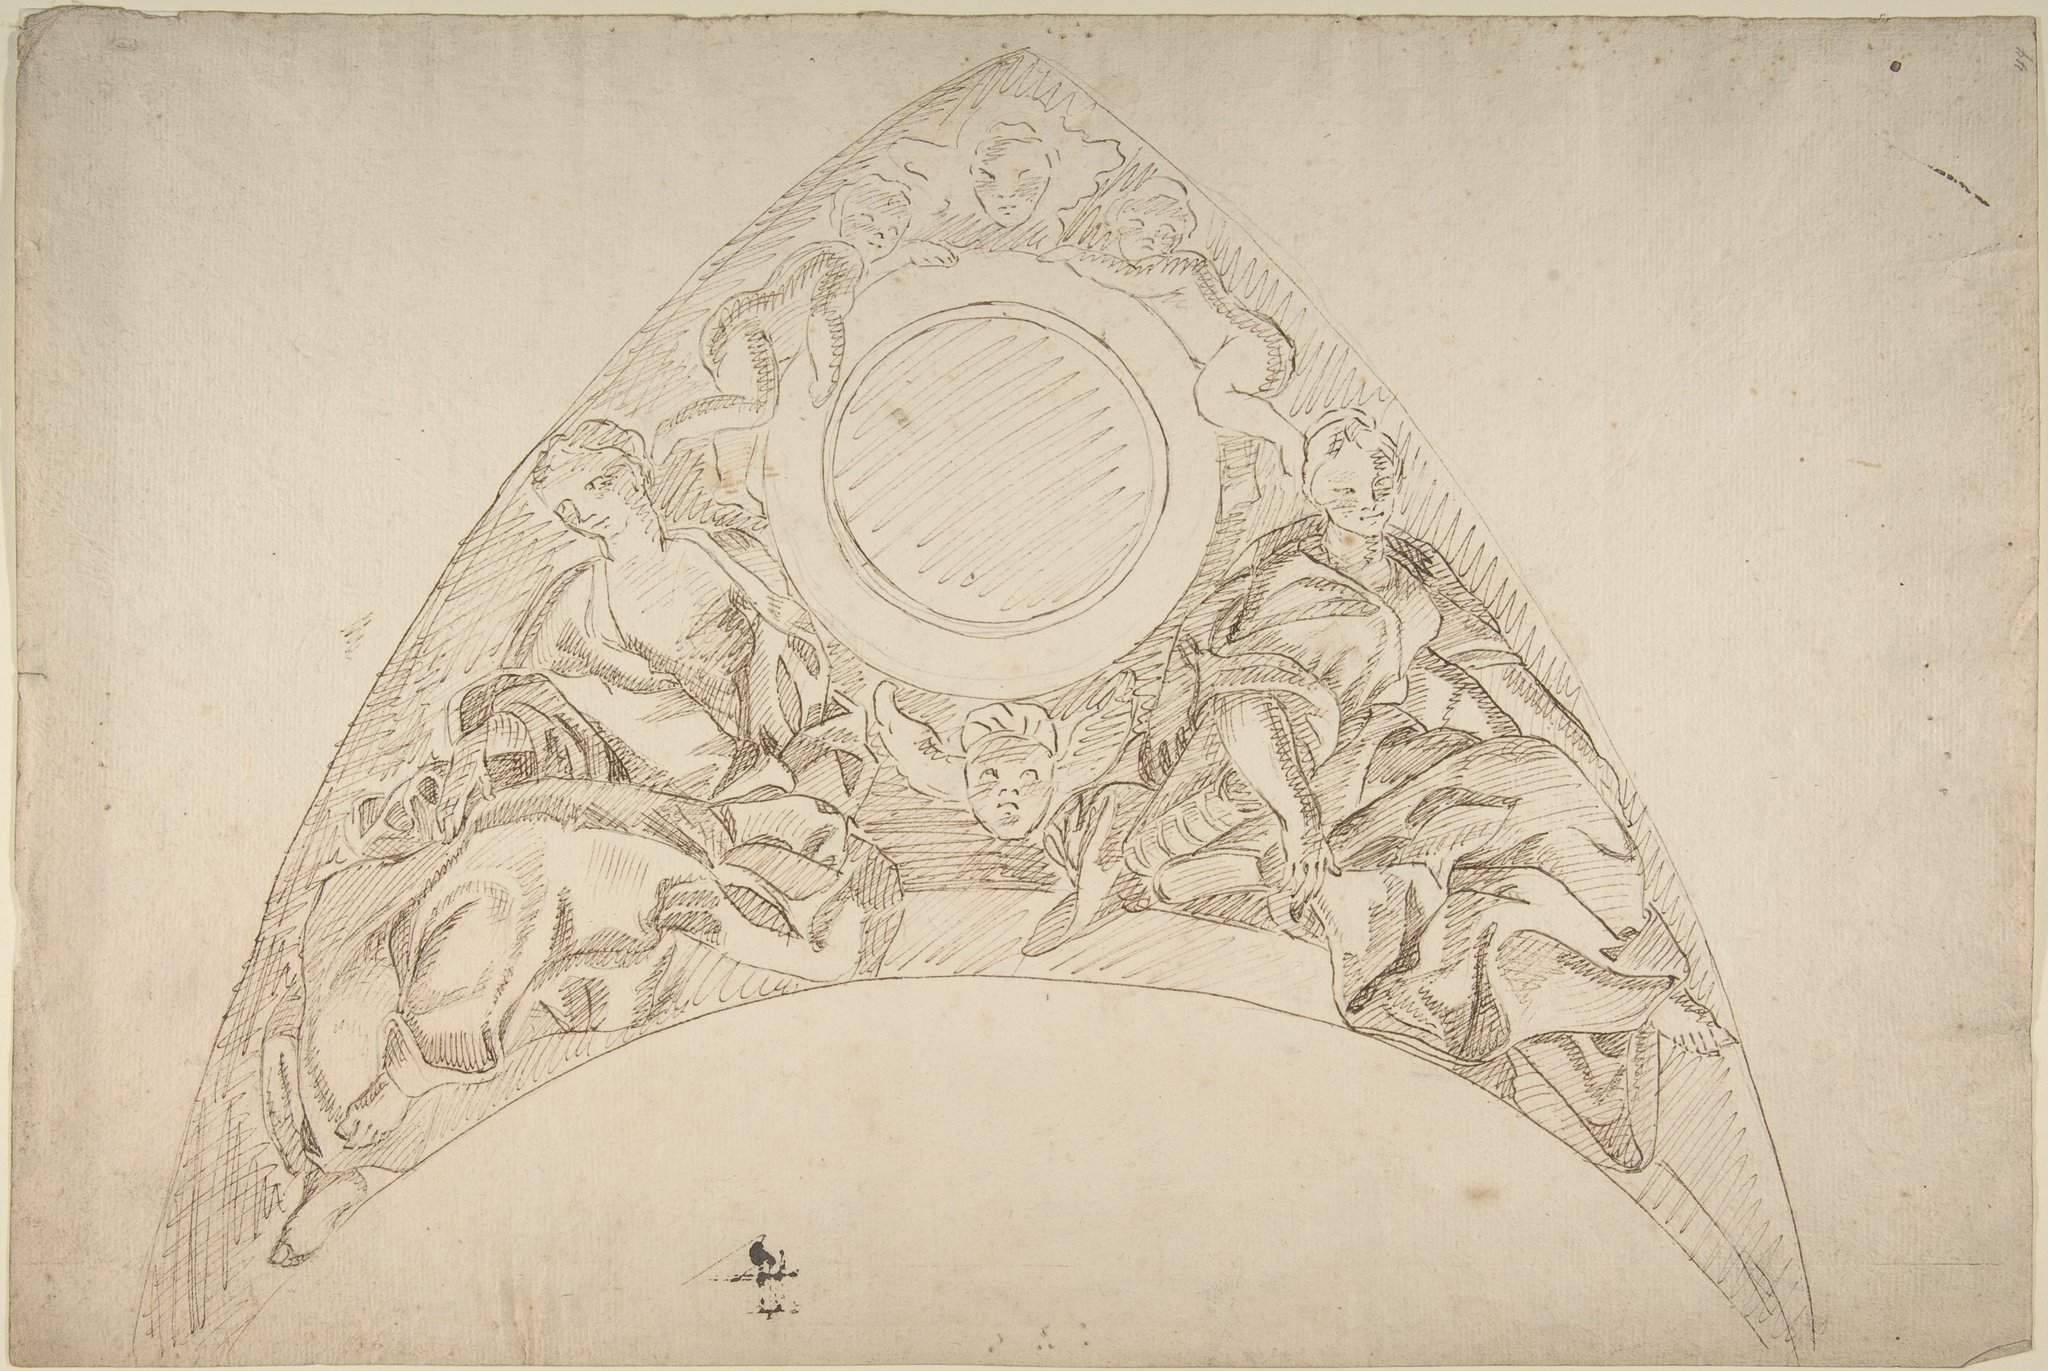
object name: drawing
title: Design for a Pedentive Decoration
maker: anonymous, italian, piedmontese, 18th century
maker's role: artist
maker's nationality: italian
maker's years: 1700-1800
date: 1701-1800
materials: ink, drawing material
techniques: pen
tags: architecture,women